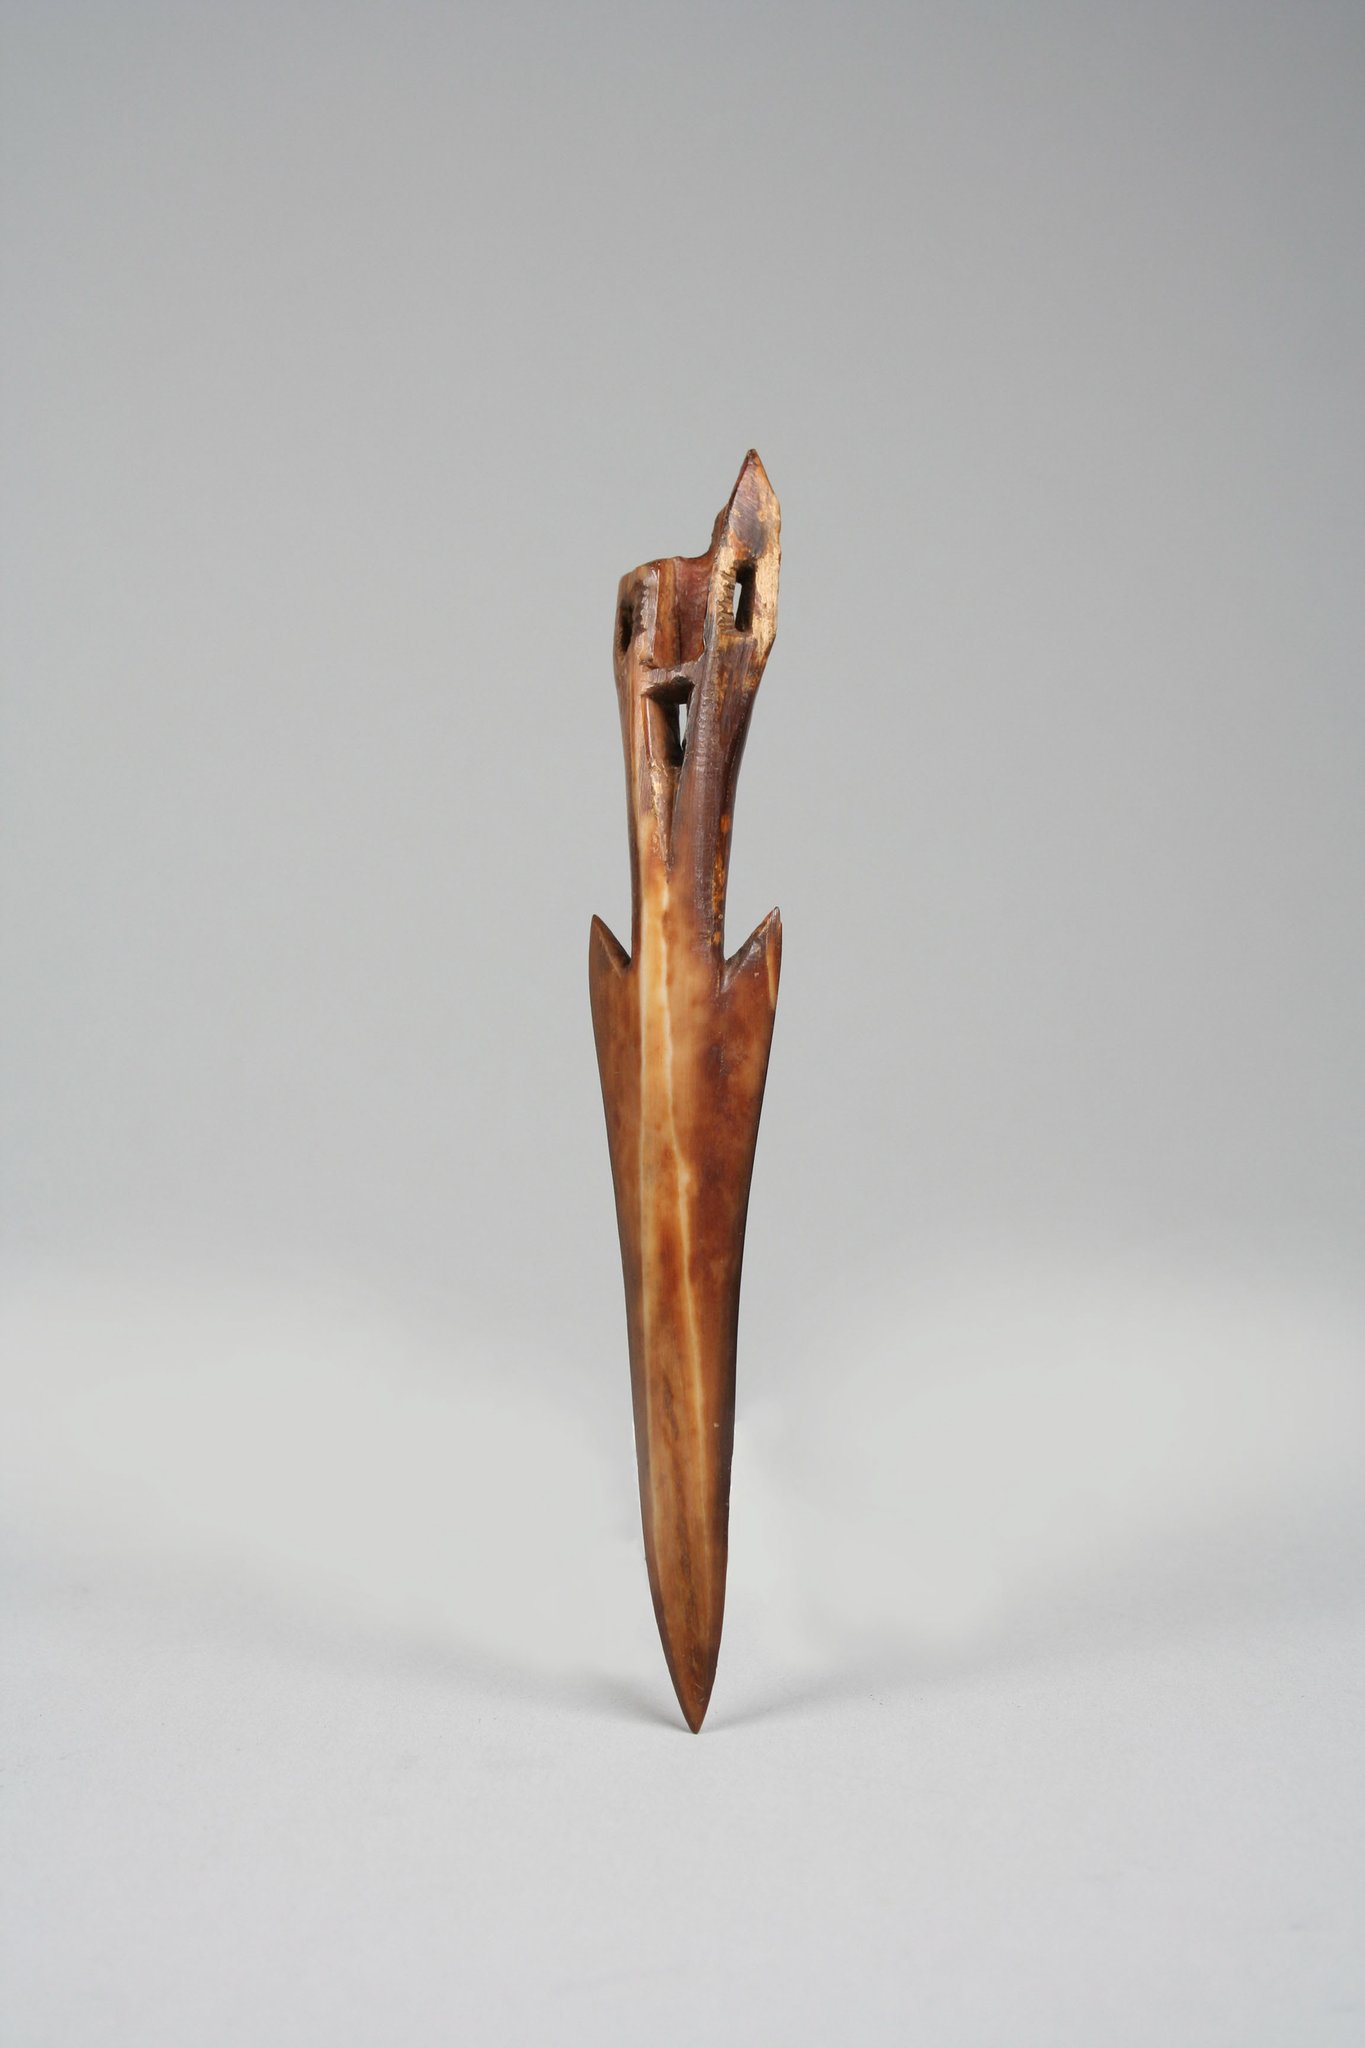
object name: harpoon head dart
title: Harpoon Head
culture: aleutian islands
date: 901-1000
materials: ivory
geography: united states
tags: weapons